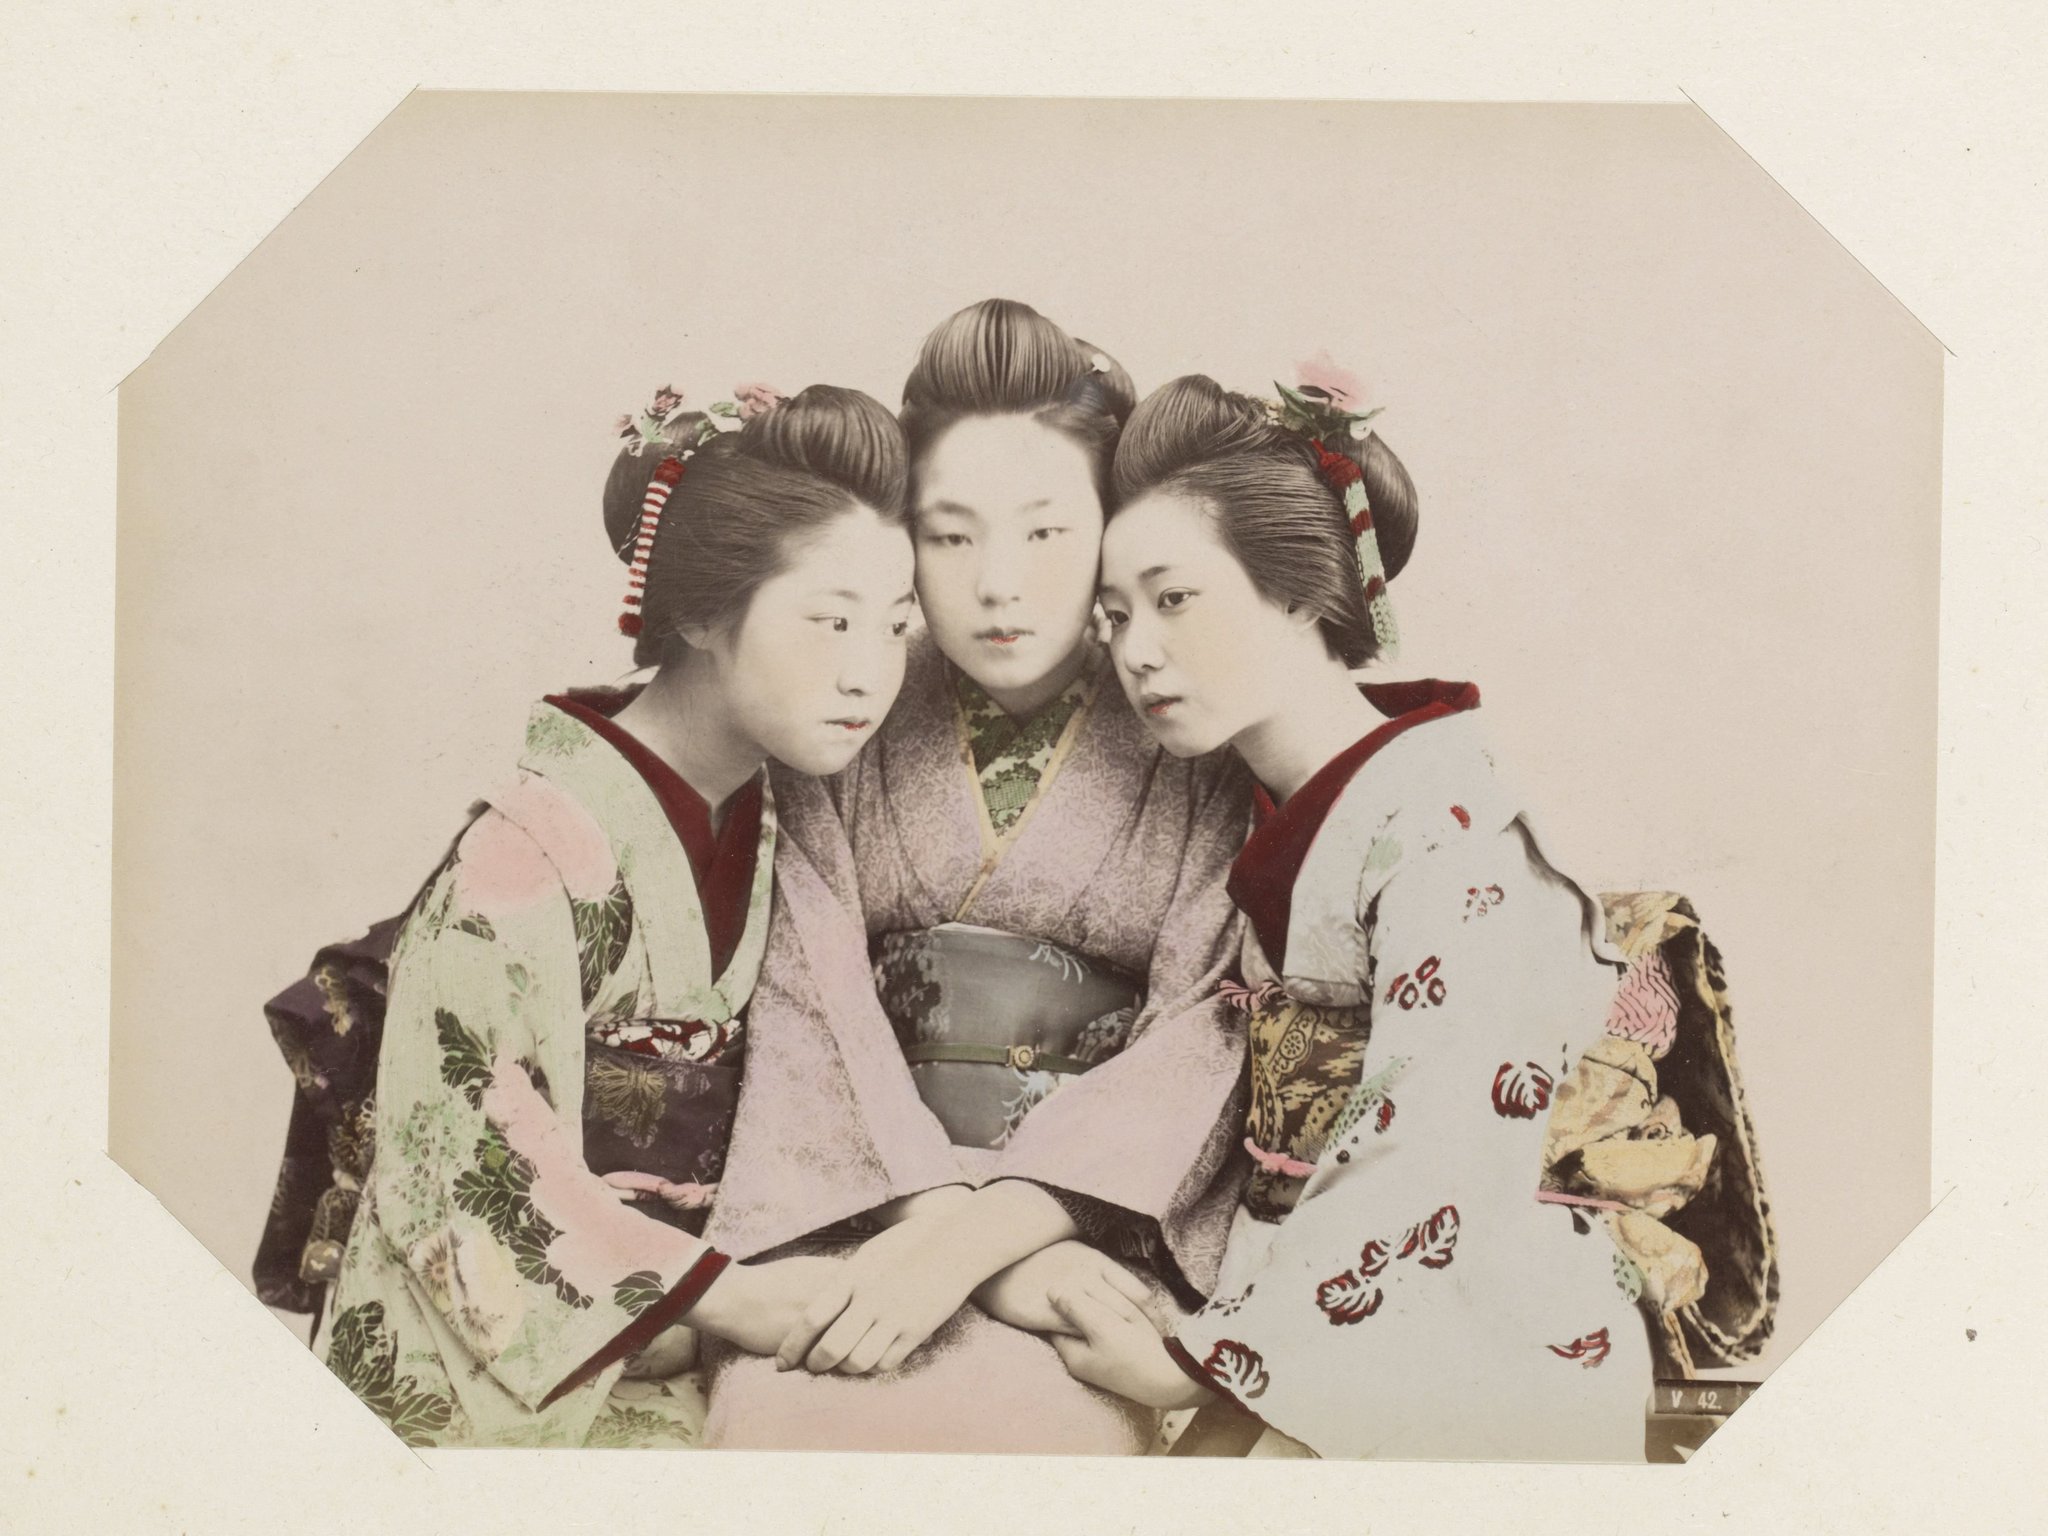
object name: photograph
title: Groepsportret van drie Japanse meisjes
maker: Anonymous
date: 1870-1900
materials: paint, photographic support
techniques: albumen print, hand coloring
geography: japan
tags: folk costume, regional costume (+ women's clothes), adolescent, young woman, maiden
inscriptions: number: ‘V 42’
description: Onderdeel van Fotoalbum met opnames van bezienswaardigheden in Japan en studioportretten.